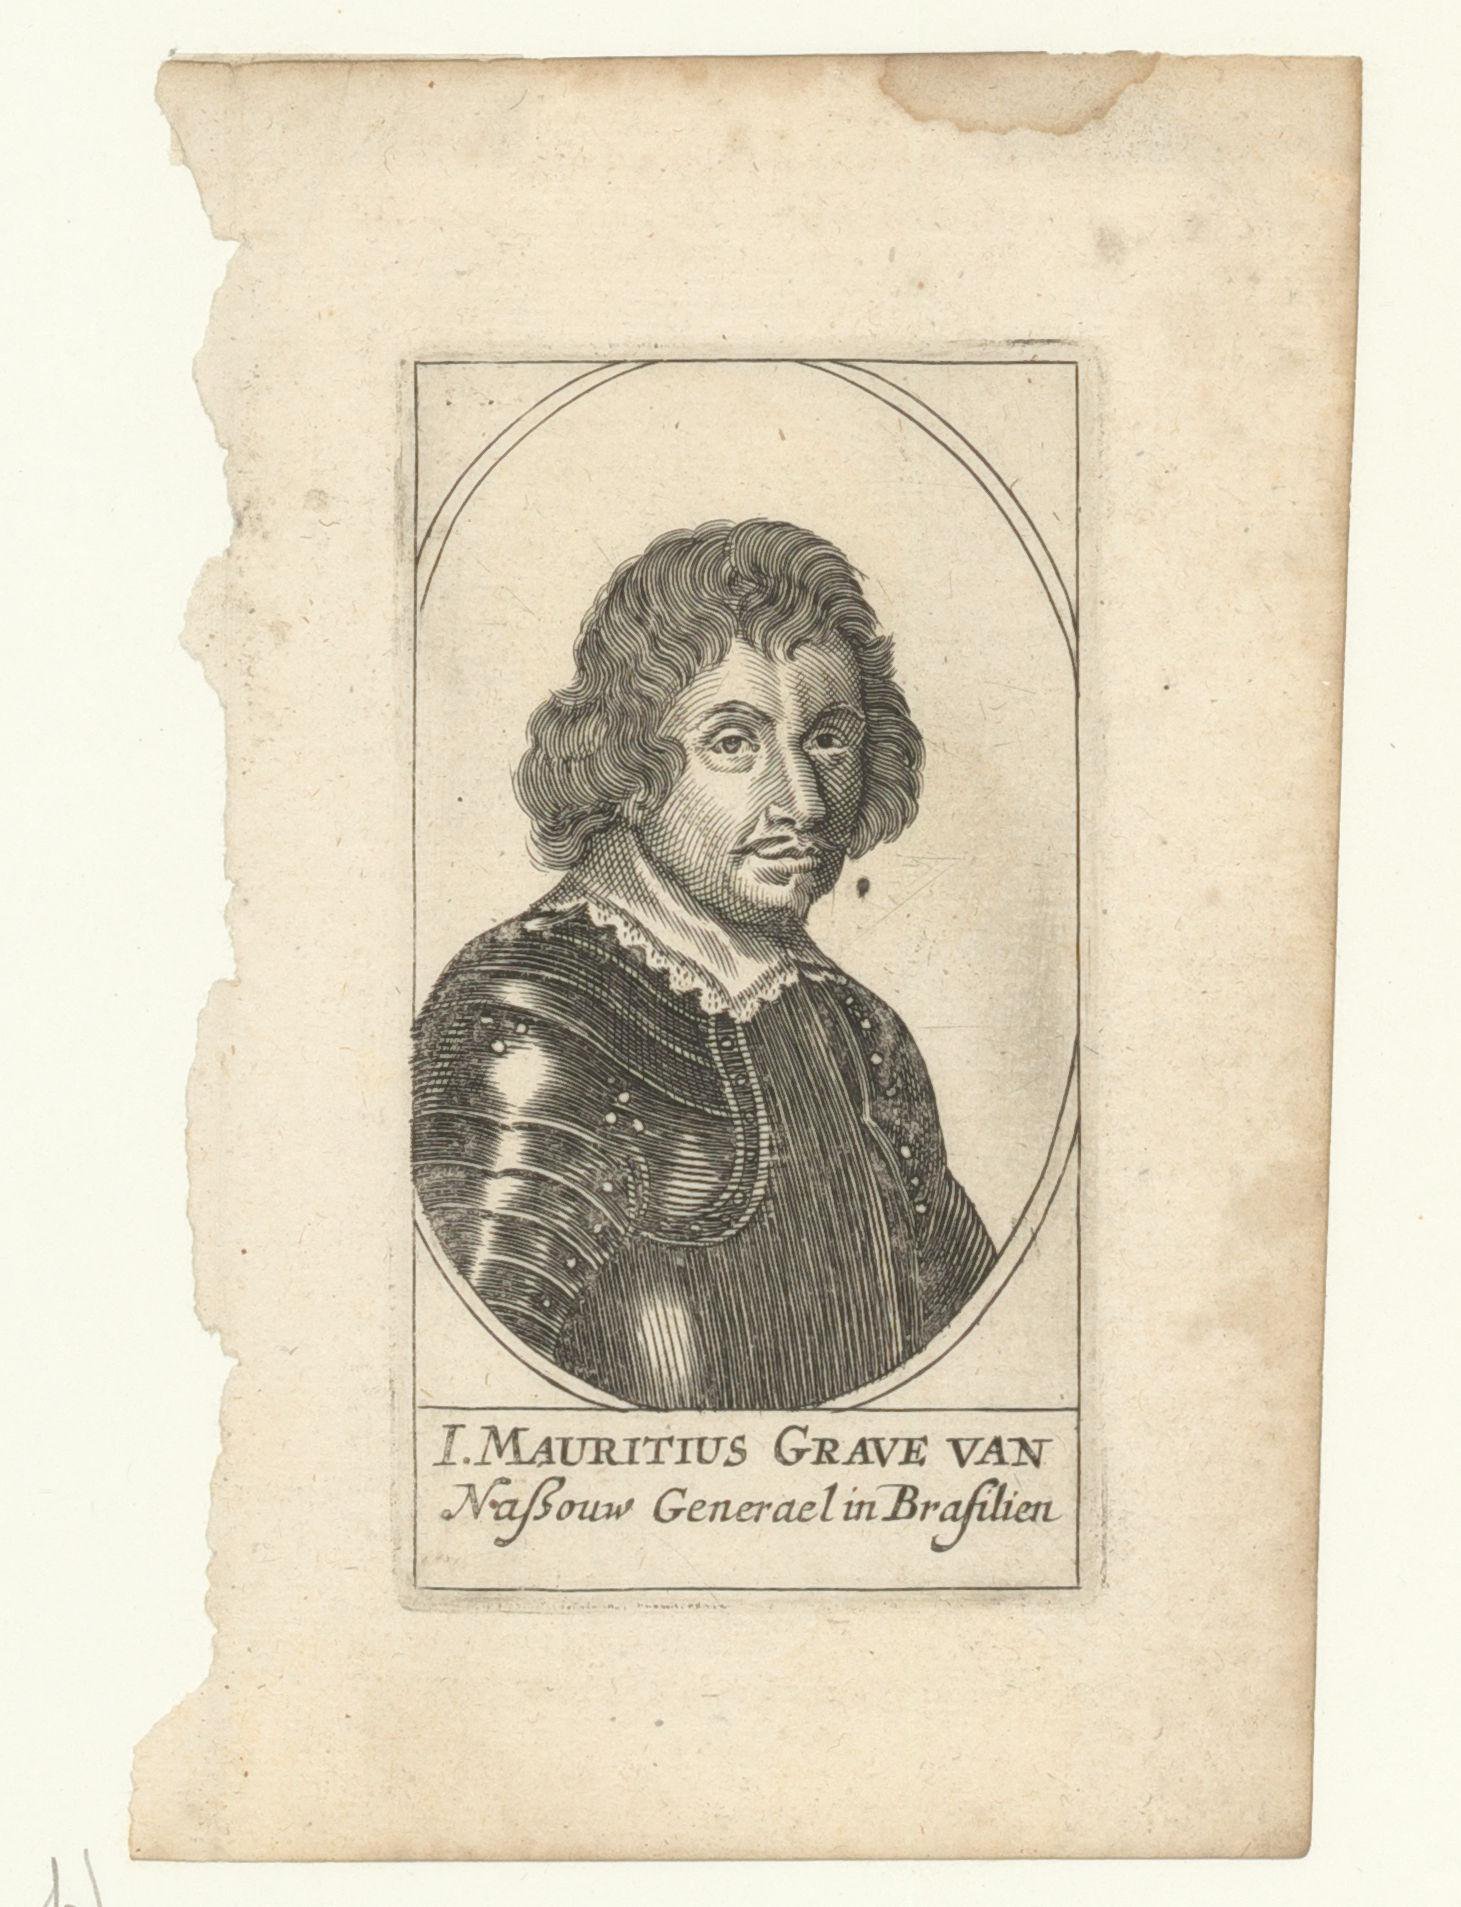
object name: print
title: Portret van Johan Maurits graaf van Nassau-Siegen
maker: Anonymous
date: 1650-1699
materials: paper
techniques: engraving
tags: earl, johan maurits graaf van nassau-siegen, colonial governor, historical persons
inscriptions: collector's mark: Lugt 1641, stamp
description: Onderwerpsrubrieken binnen de Atlas Zeden en Gewoonten: Portretten, Portretten van Vorsten uit het huis van Oranje, Niet regeerende Vorsten.